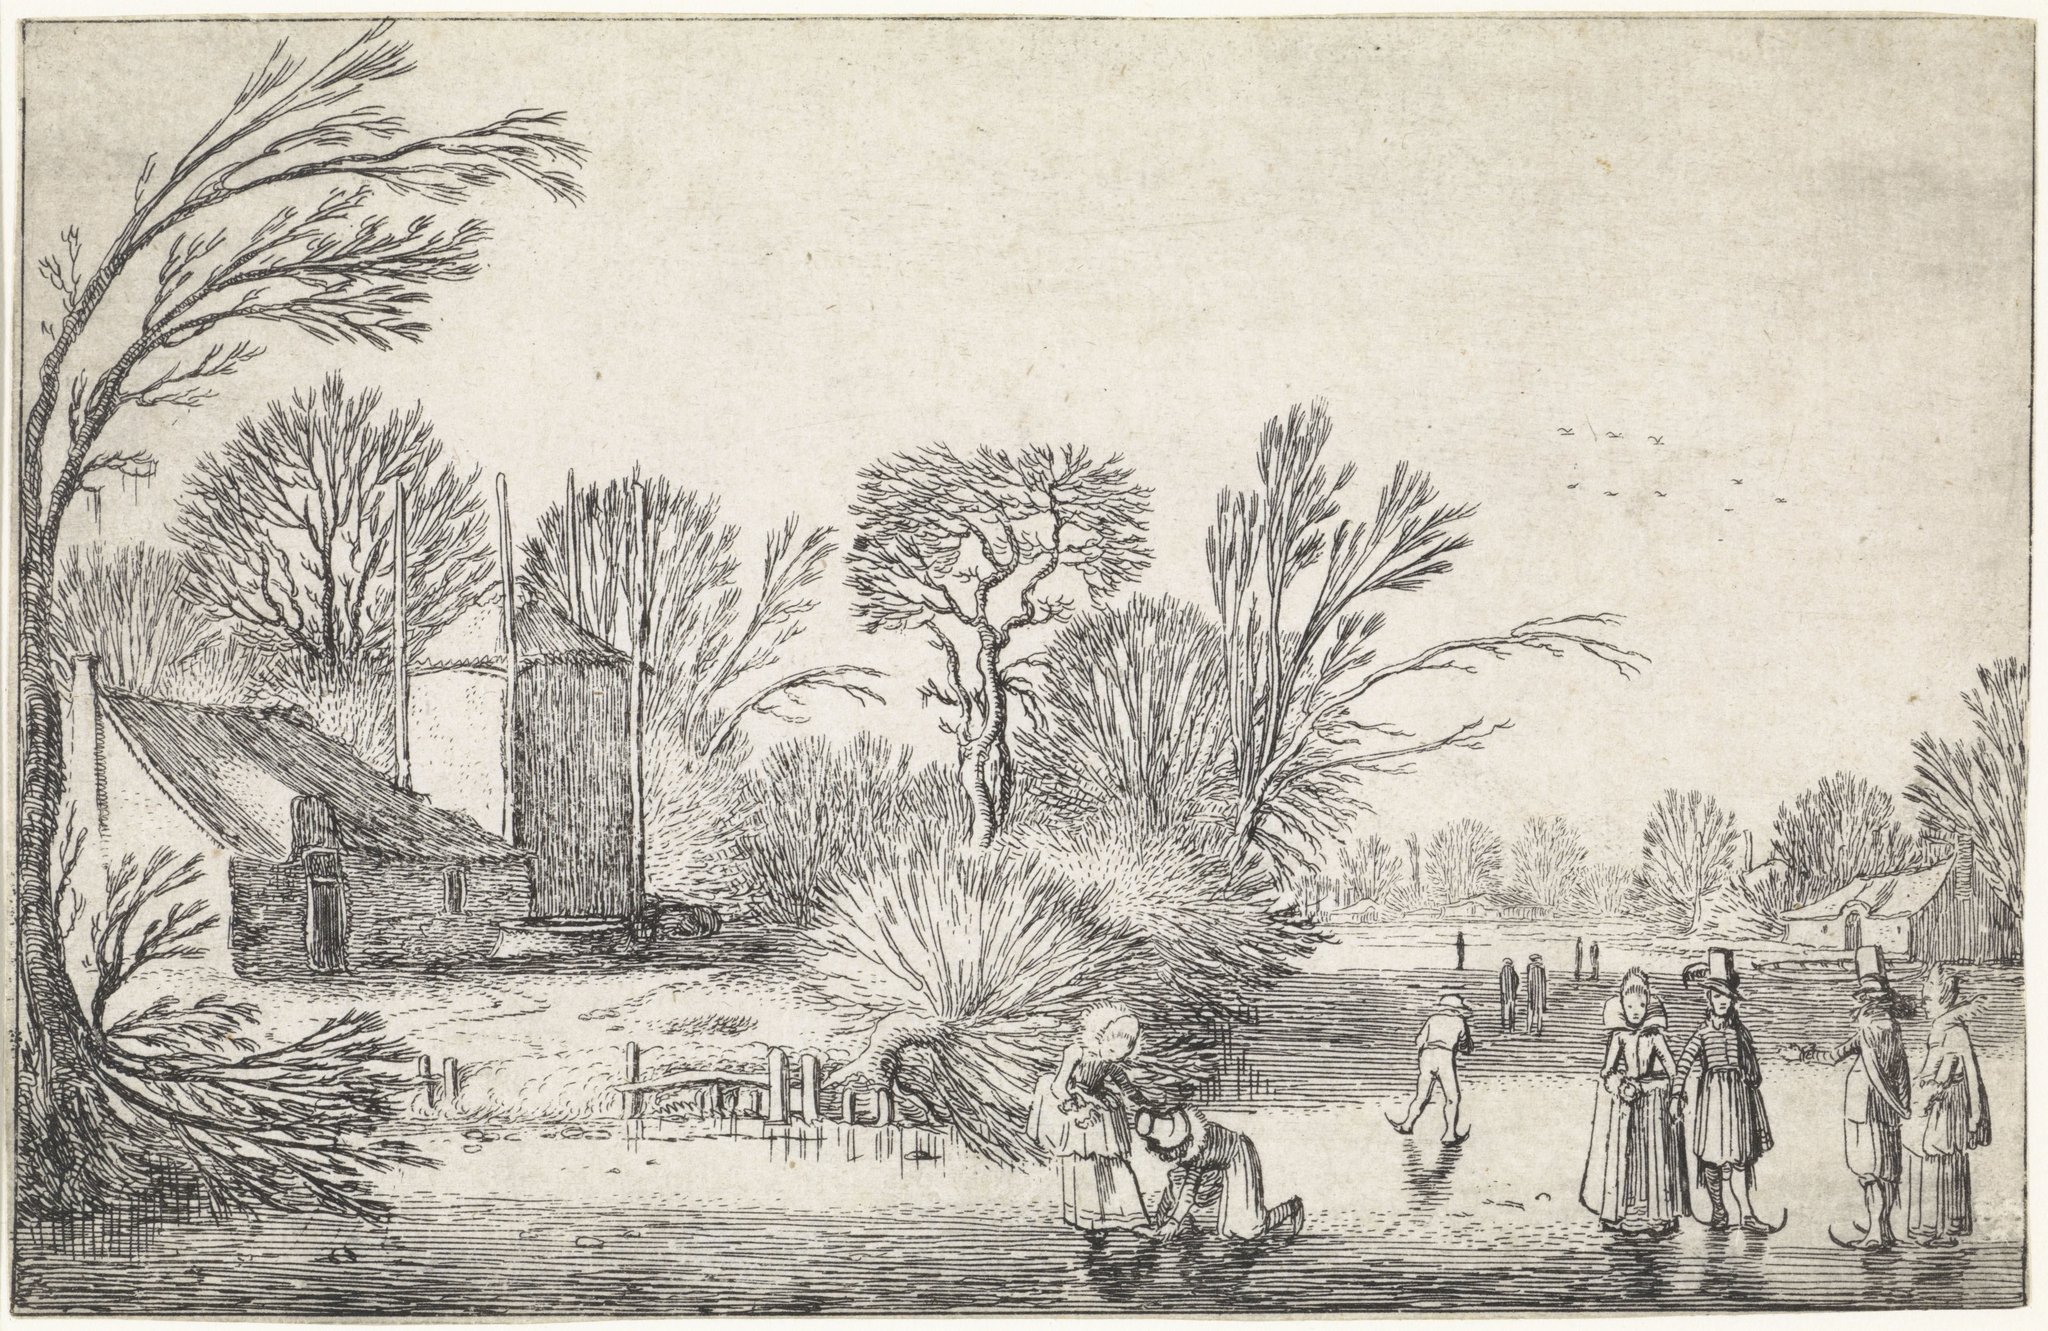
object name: print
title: Amenissimae aliquot requculae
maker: jan van de velde (ii)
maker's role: draughtsman, painter, print maker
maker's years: 1593-1641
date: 1616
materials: paper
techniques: etching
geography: northern netherlands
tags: skates (winter sports), hay-stack, farm (building)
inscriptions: collector's mark: Lugt 2760, collector's mark: Lugt 2228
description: F.K. 322 I. Oorspronkelijk vormden de eerste staten van de prenten een serie bestaande uit twee delen van elk 26 prenten. De latere staten vormden een serie van vijf delen van elk twaalf prenten.